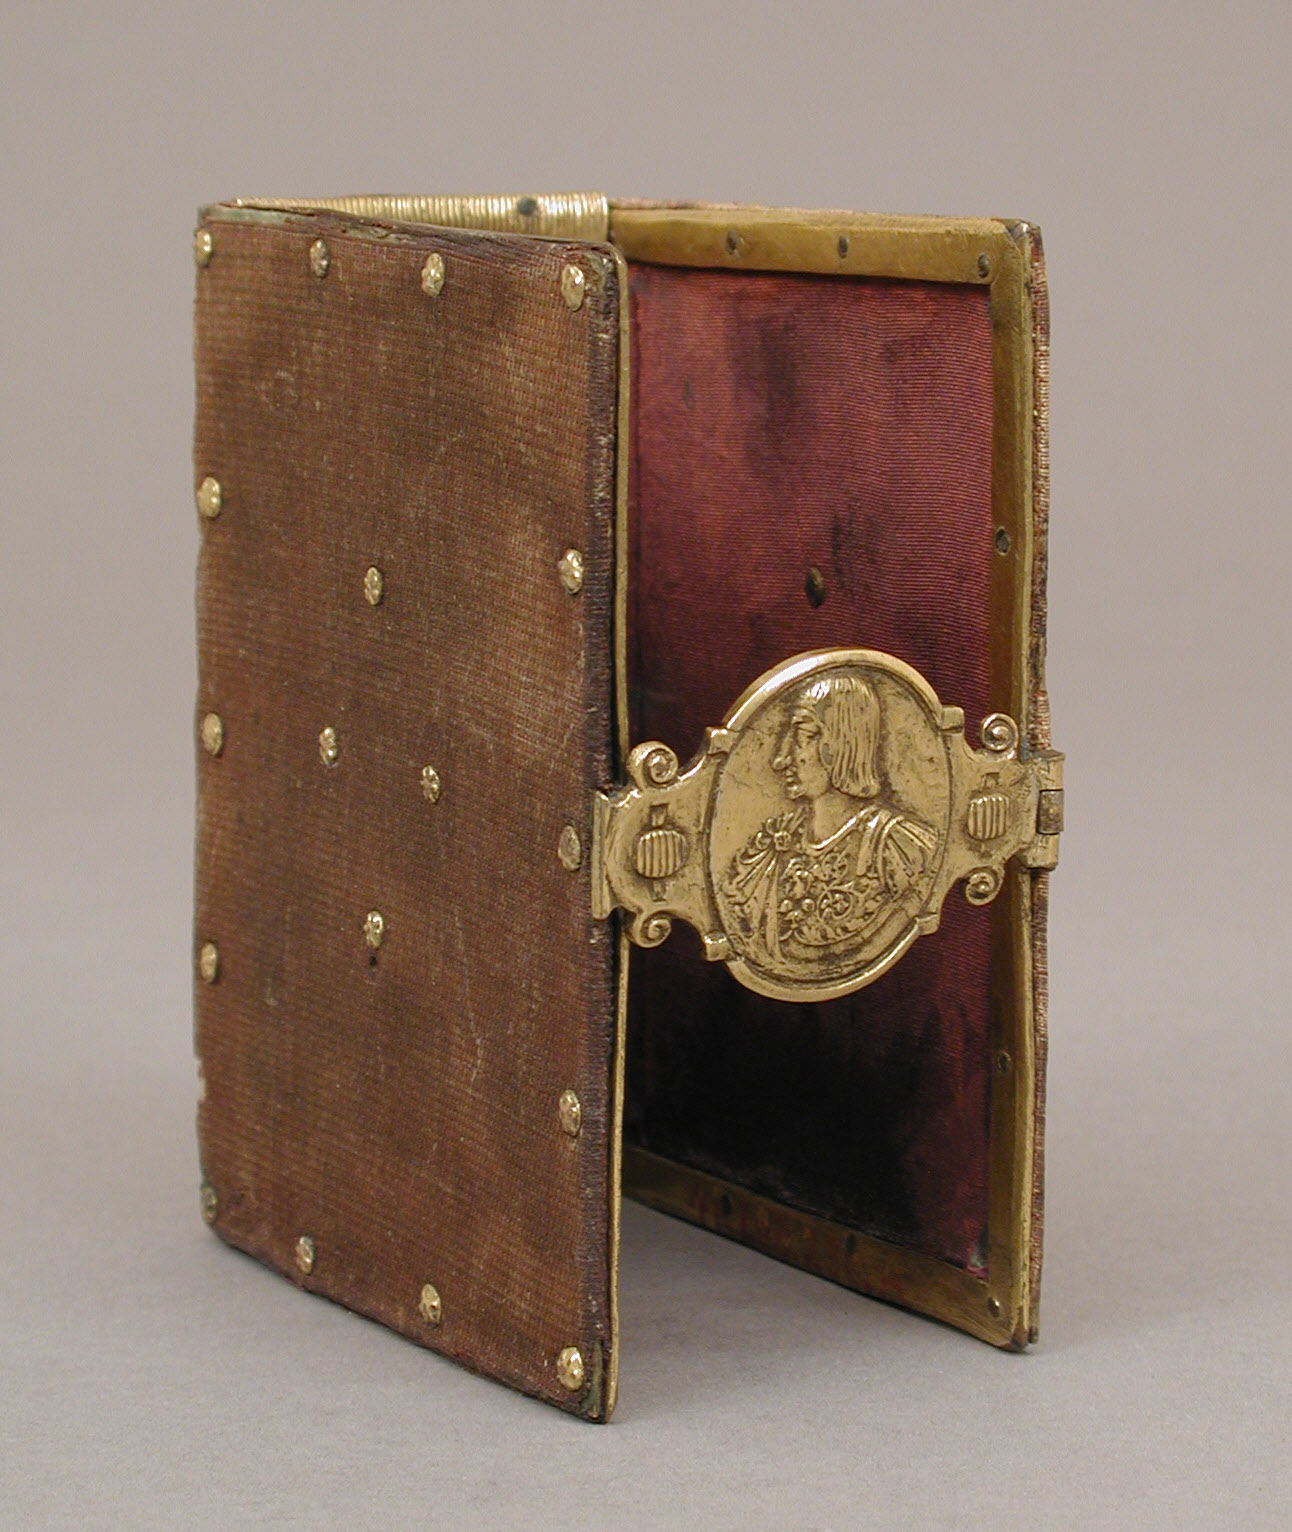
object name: frame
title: Frame in the form of a book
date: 1851-1900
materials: gilt bronze, velvet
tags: men,profiles